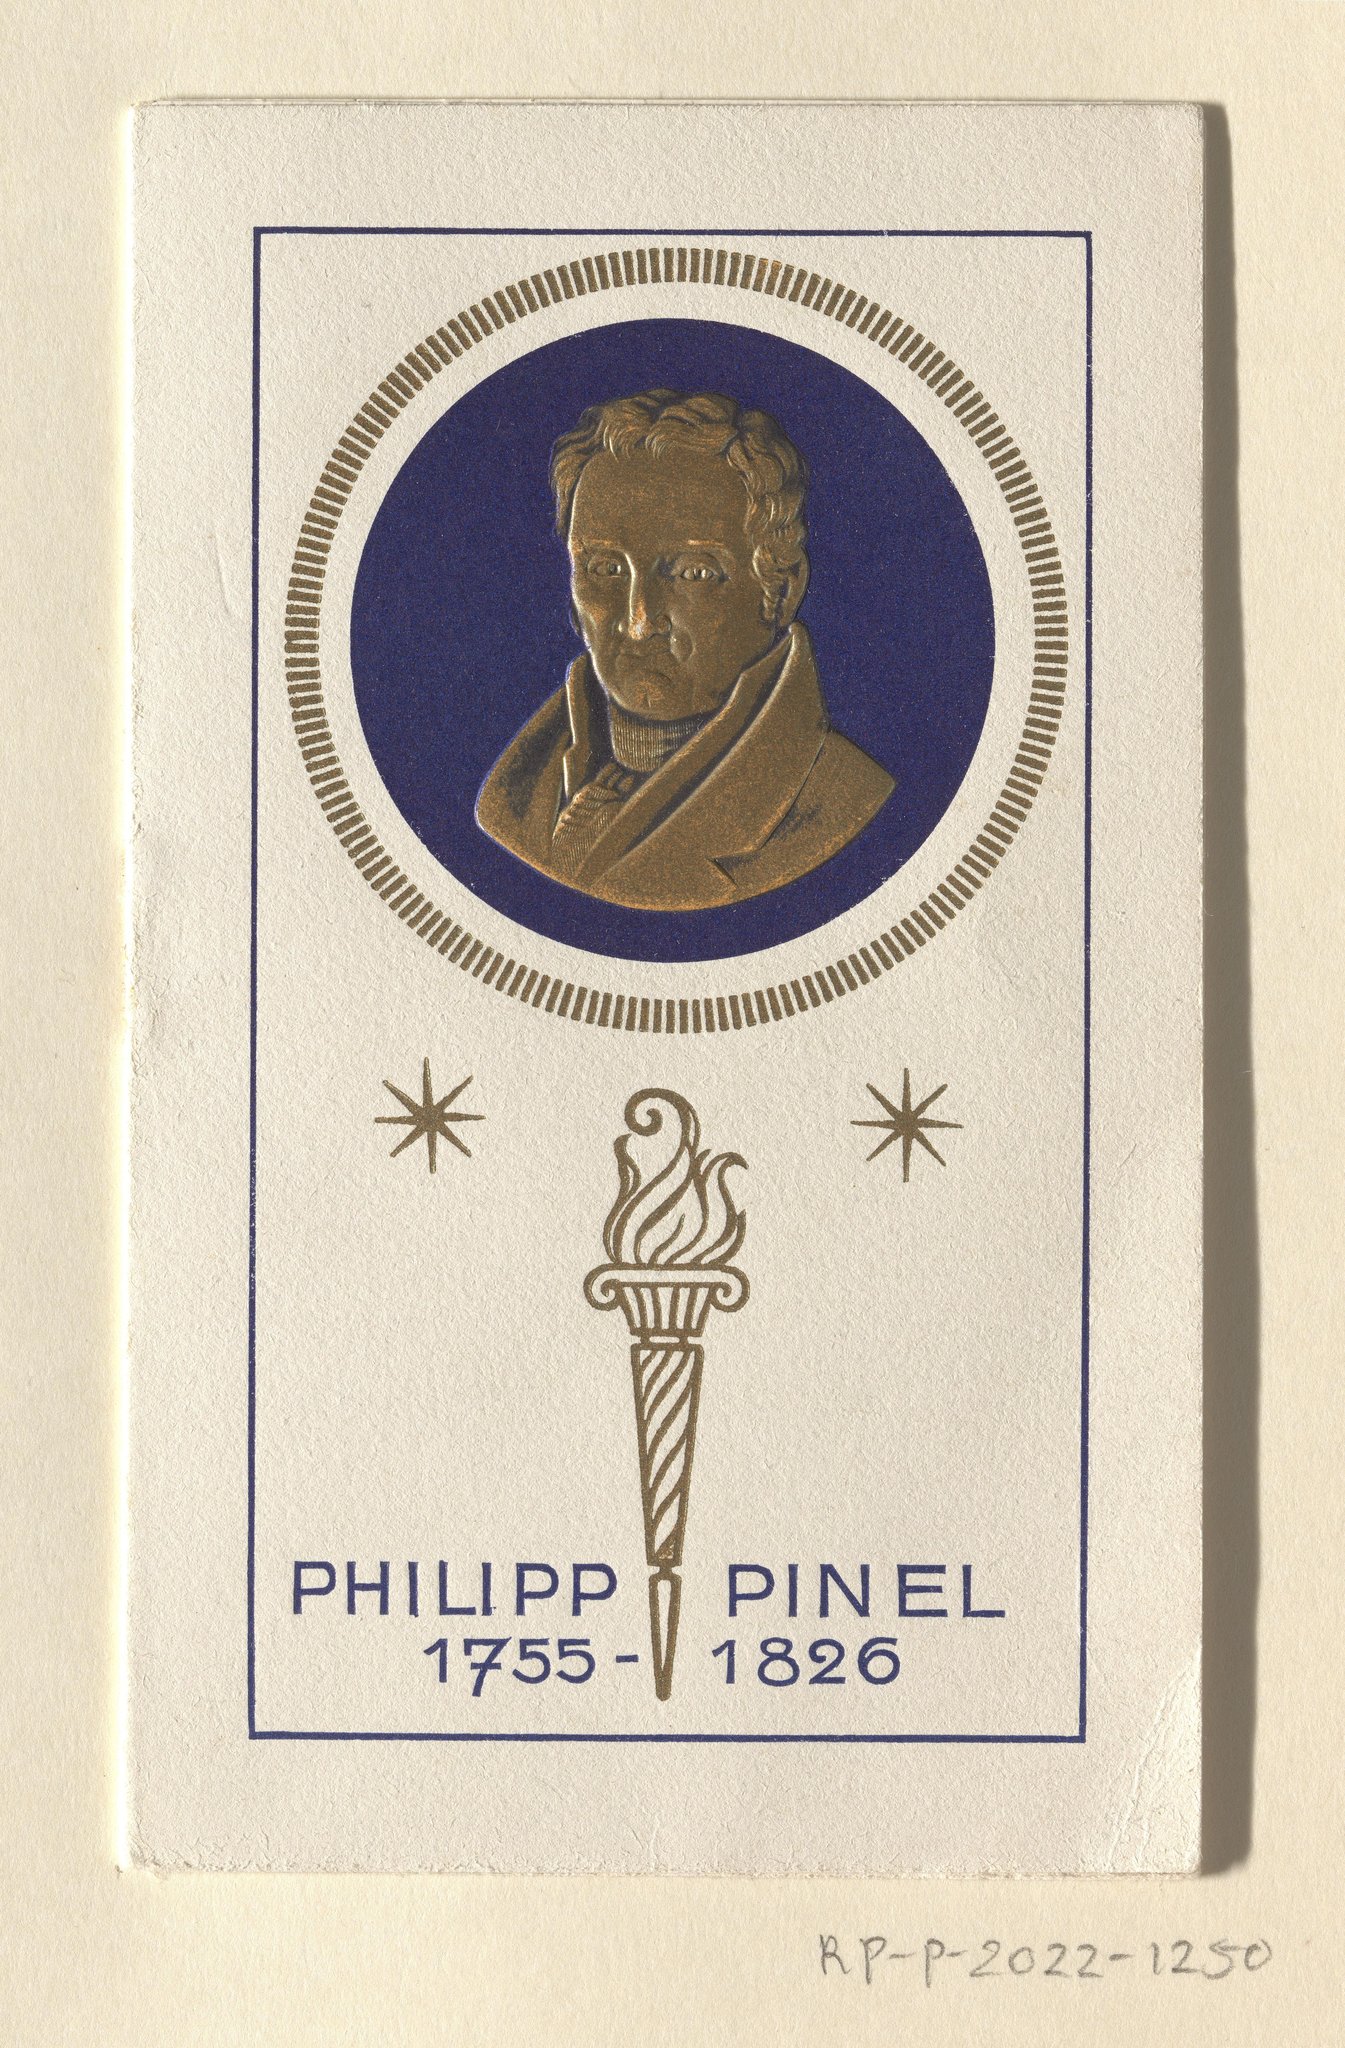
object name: print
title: Philippe Pinel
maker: Anonymous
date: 1910-1915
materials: paper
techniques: blind stamped, lithograph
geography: germany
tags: paris, advertising, physician, doctor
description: Kaart met portretbuste van de arts Philippe Pinel. Met binnenin tekstbladen. Onderdeel van de serie kaarten in reliëfdruk uitgebracht als reclame voor de medische producten van Tropon-Werke, Mülheim am Rhein.